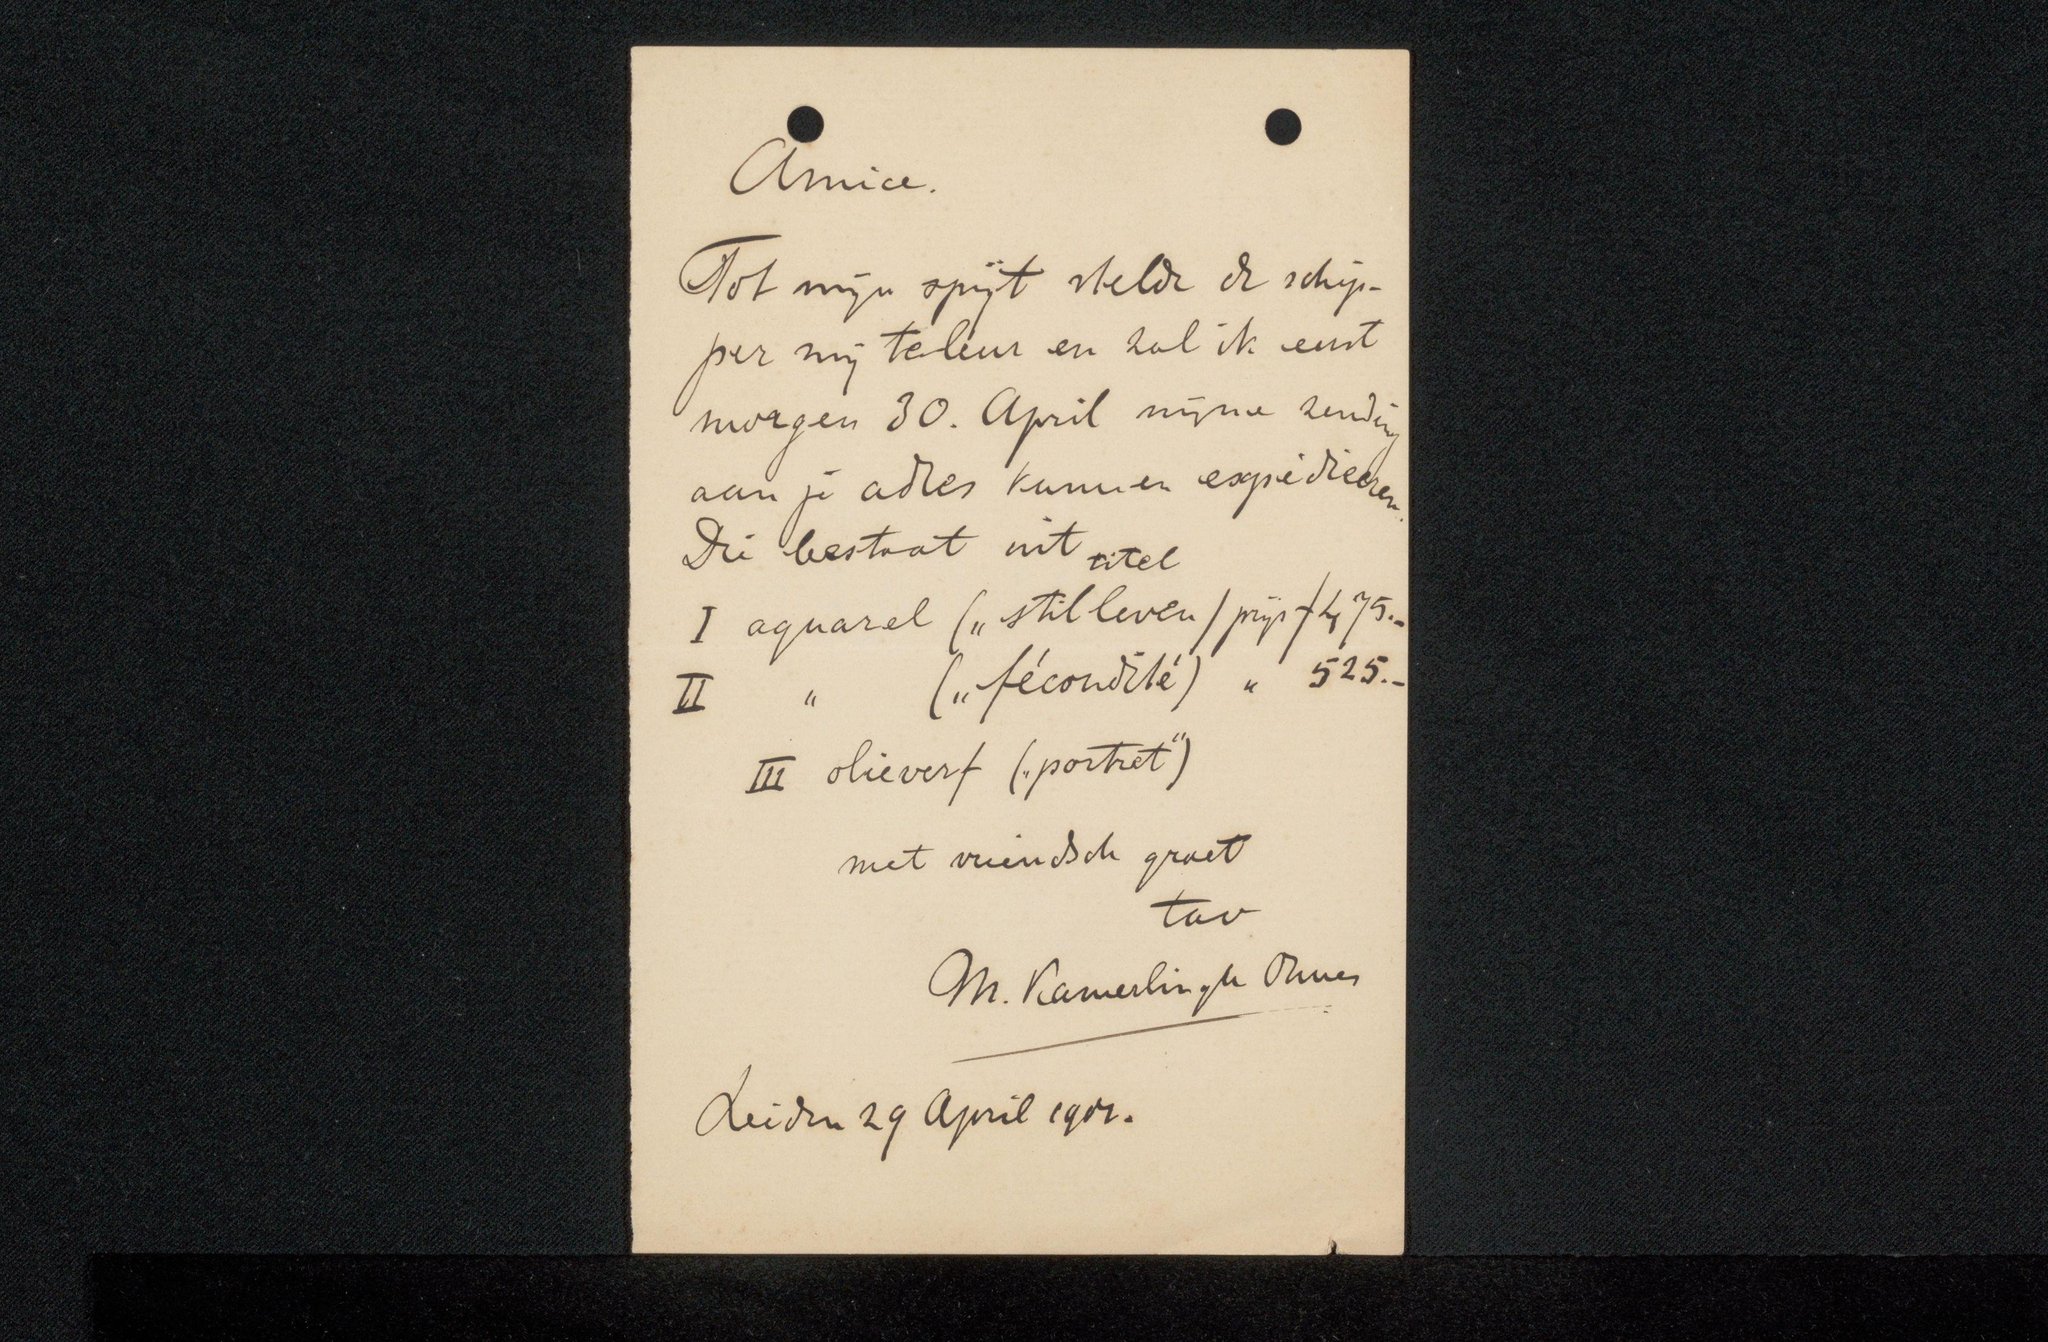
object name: letter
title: Brief aan Philip Zilcken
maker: menso kamerlingh onnes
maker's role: painter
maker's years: 1860-1925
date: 1901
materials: ink, paper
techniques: pen, writing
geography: leiden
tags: the hague, painter, draughtsman, philip zilcken, drawing, sending and receiving postal matter, painting (including book-illumination, miniature-painting), money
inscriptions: collector's mark: ‘RPK’